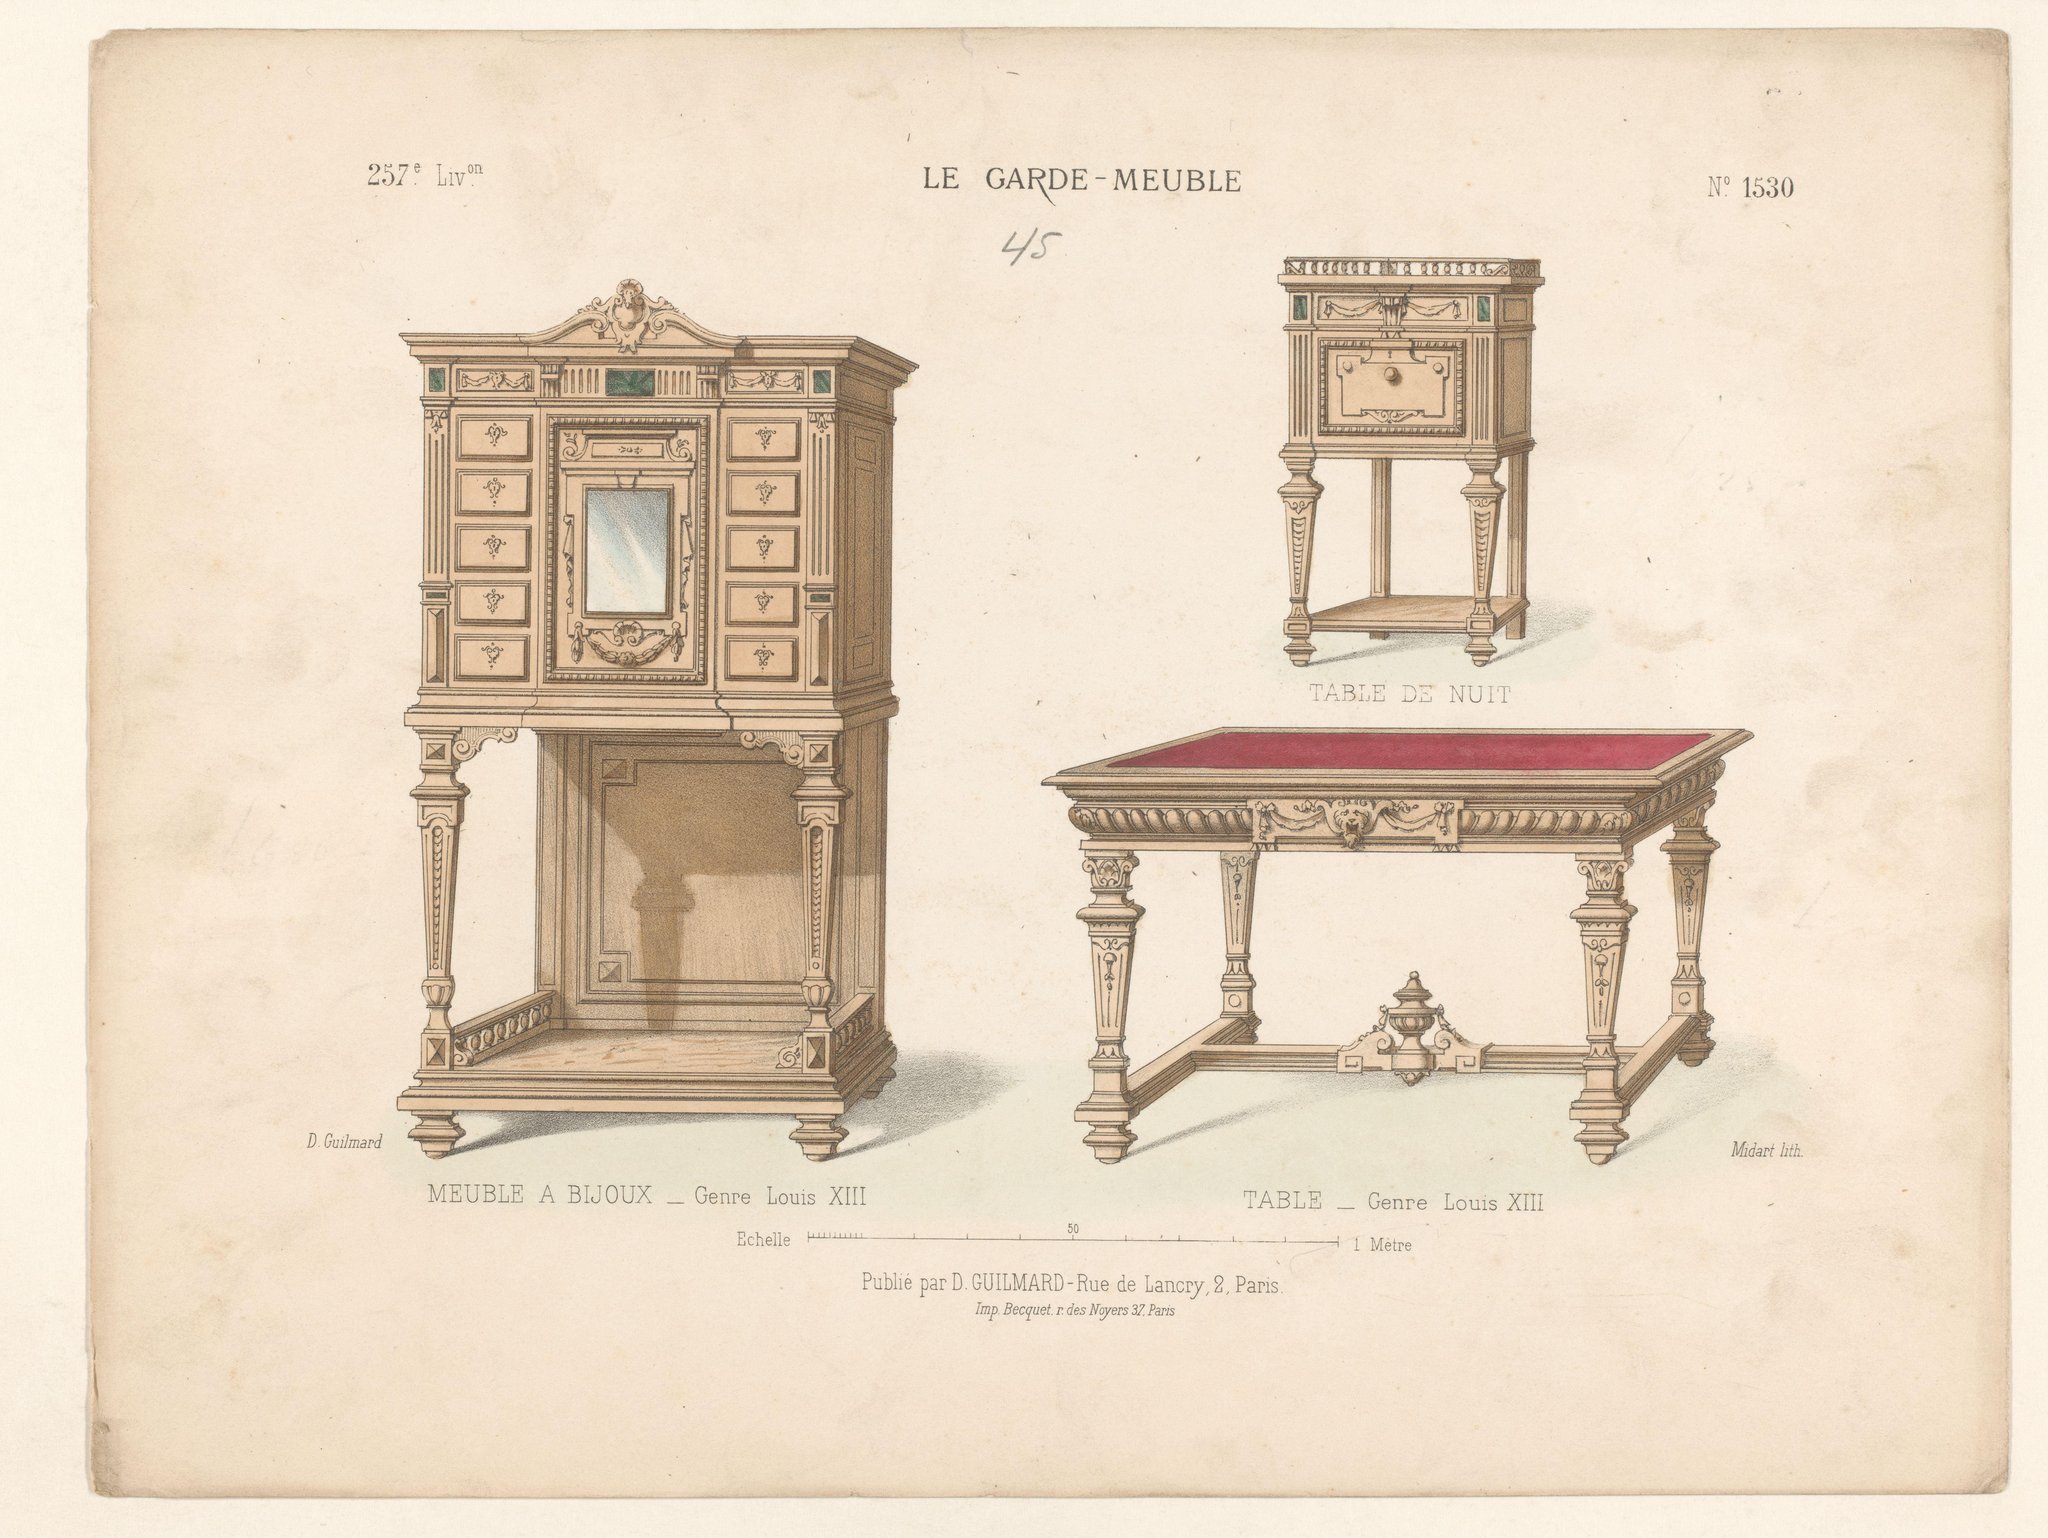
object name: print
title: Le garde-meuble / Collection de Meubles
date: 1839-1885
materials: paper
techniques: hand coloring, lithograph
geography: paris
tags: furniture for storage, table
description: Ieder Livraison in de serie Le Garde-Meuble bevat negen platen: drie 'sièges' (zitmeubels), drie 'meubles' (diverse meubels zoals tafels en kasten) en drie 'tentures' (gordijnen en draperieën).